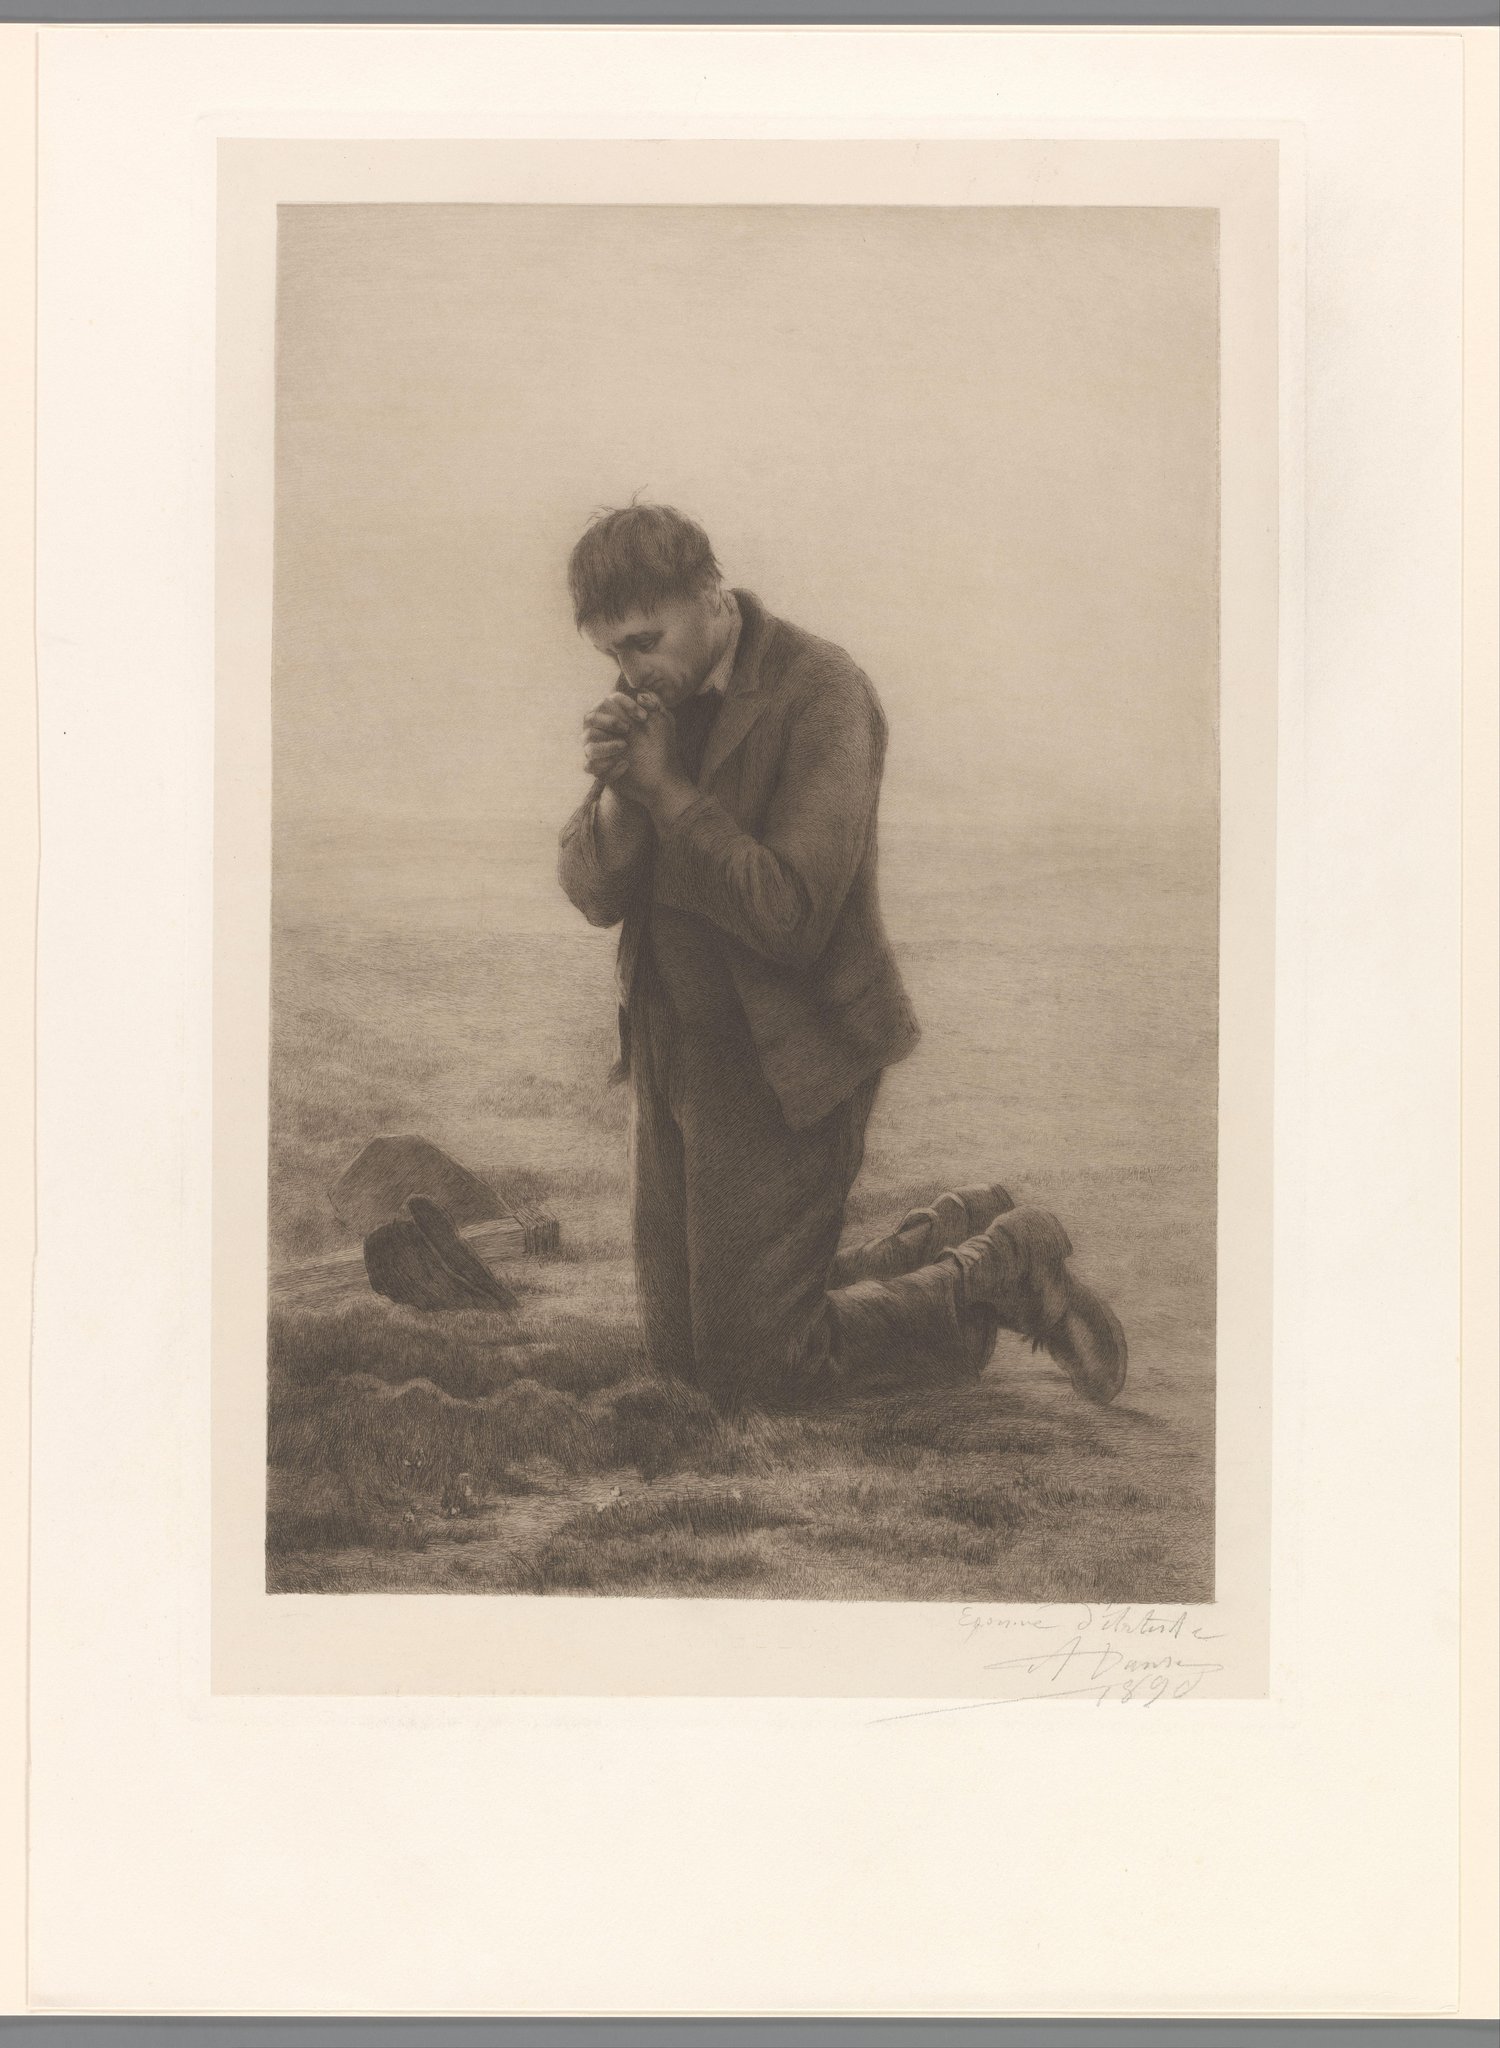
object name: print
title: Landarbeider knielt in het veld voor zijn gebed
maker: auguste danse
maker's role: print maker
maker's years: 1829-1929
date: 1898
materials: paper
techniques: drypoint, etching, intaglio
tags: daily (vocal) prayer by one person, farmers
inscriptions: collector's mark: Lugt 2228, annotation: ‘Epreuve d'artiste’